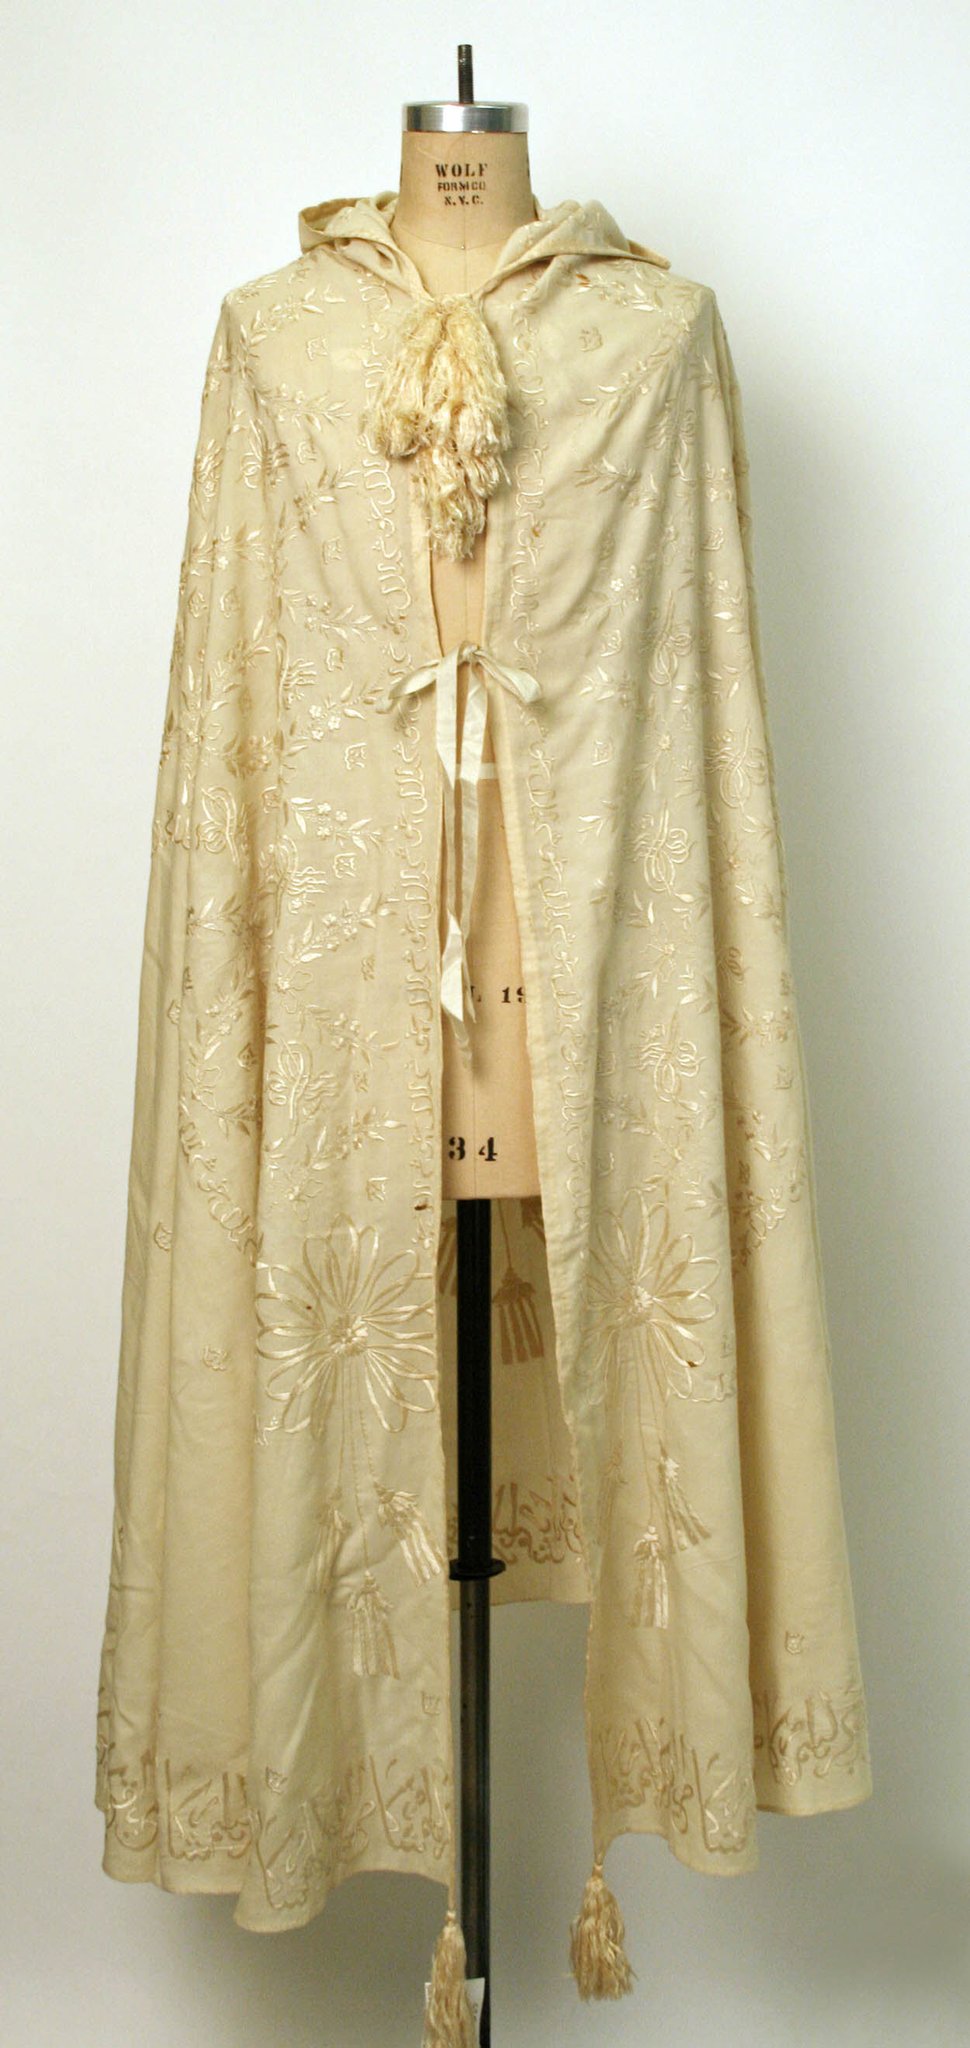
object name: cape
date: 1871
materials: silk, wool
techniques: embroidery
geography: iraq